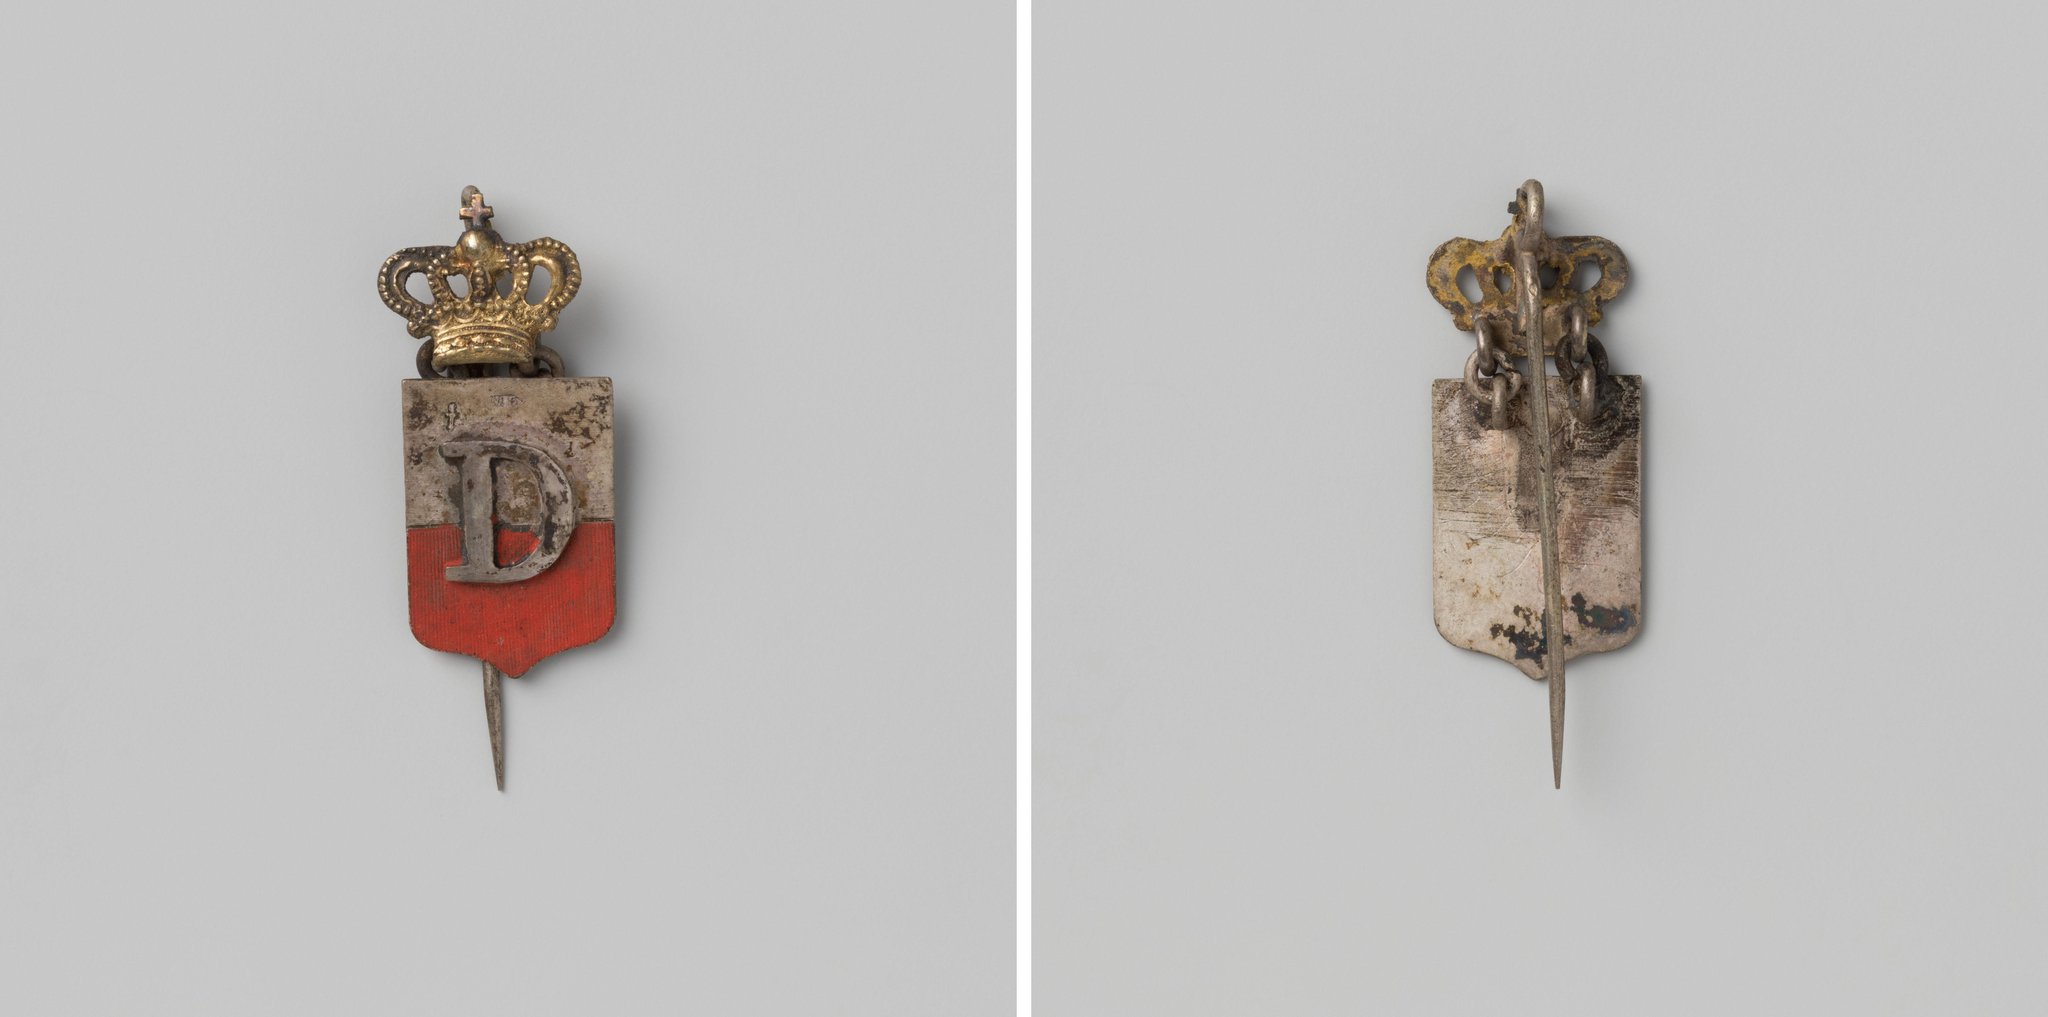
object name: insignia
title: Insigne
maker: Anonymous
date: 1825-1875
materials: silver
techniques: striking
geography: netherlands